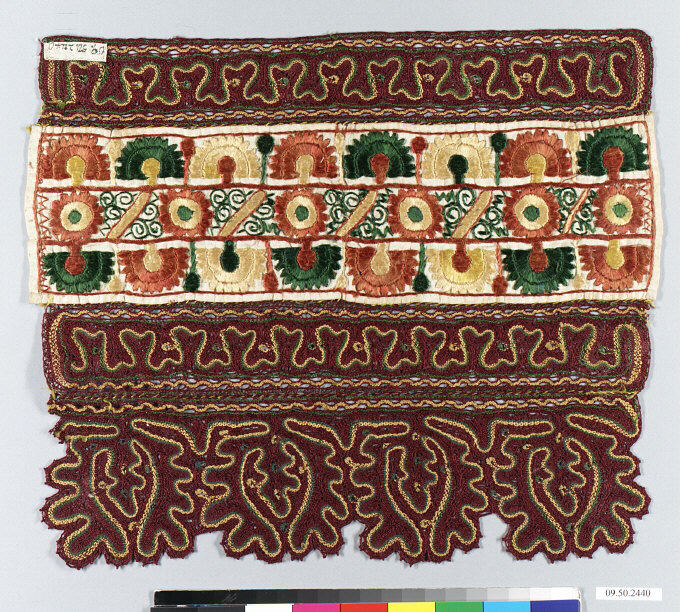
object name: cuff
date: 1867-1900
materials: linen, silk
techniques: lace, embroidery